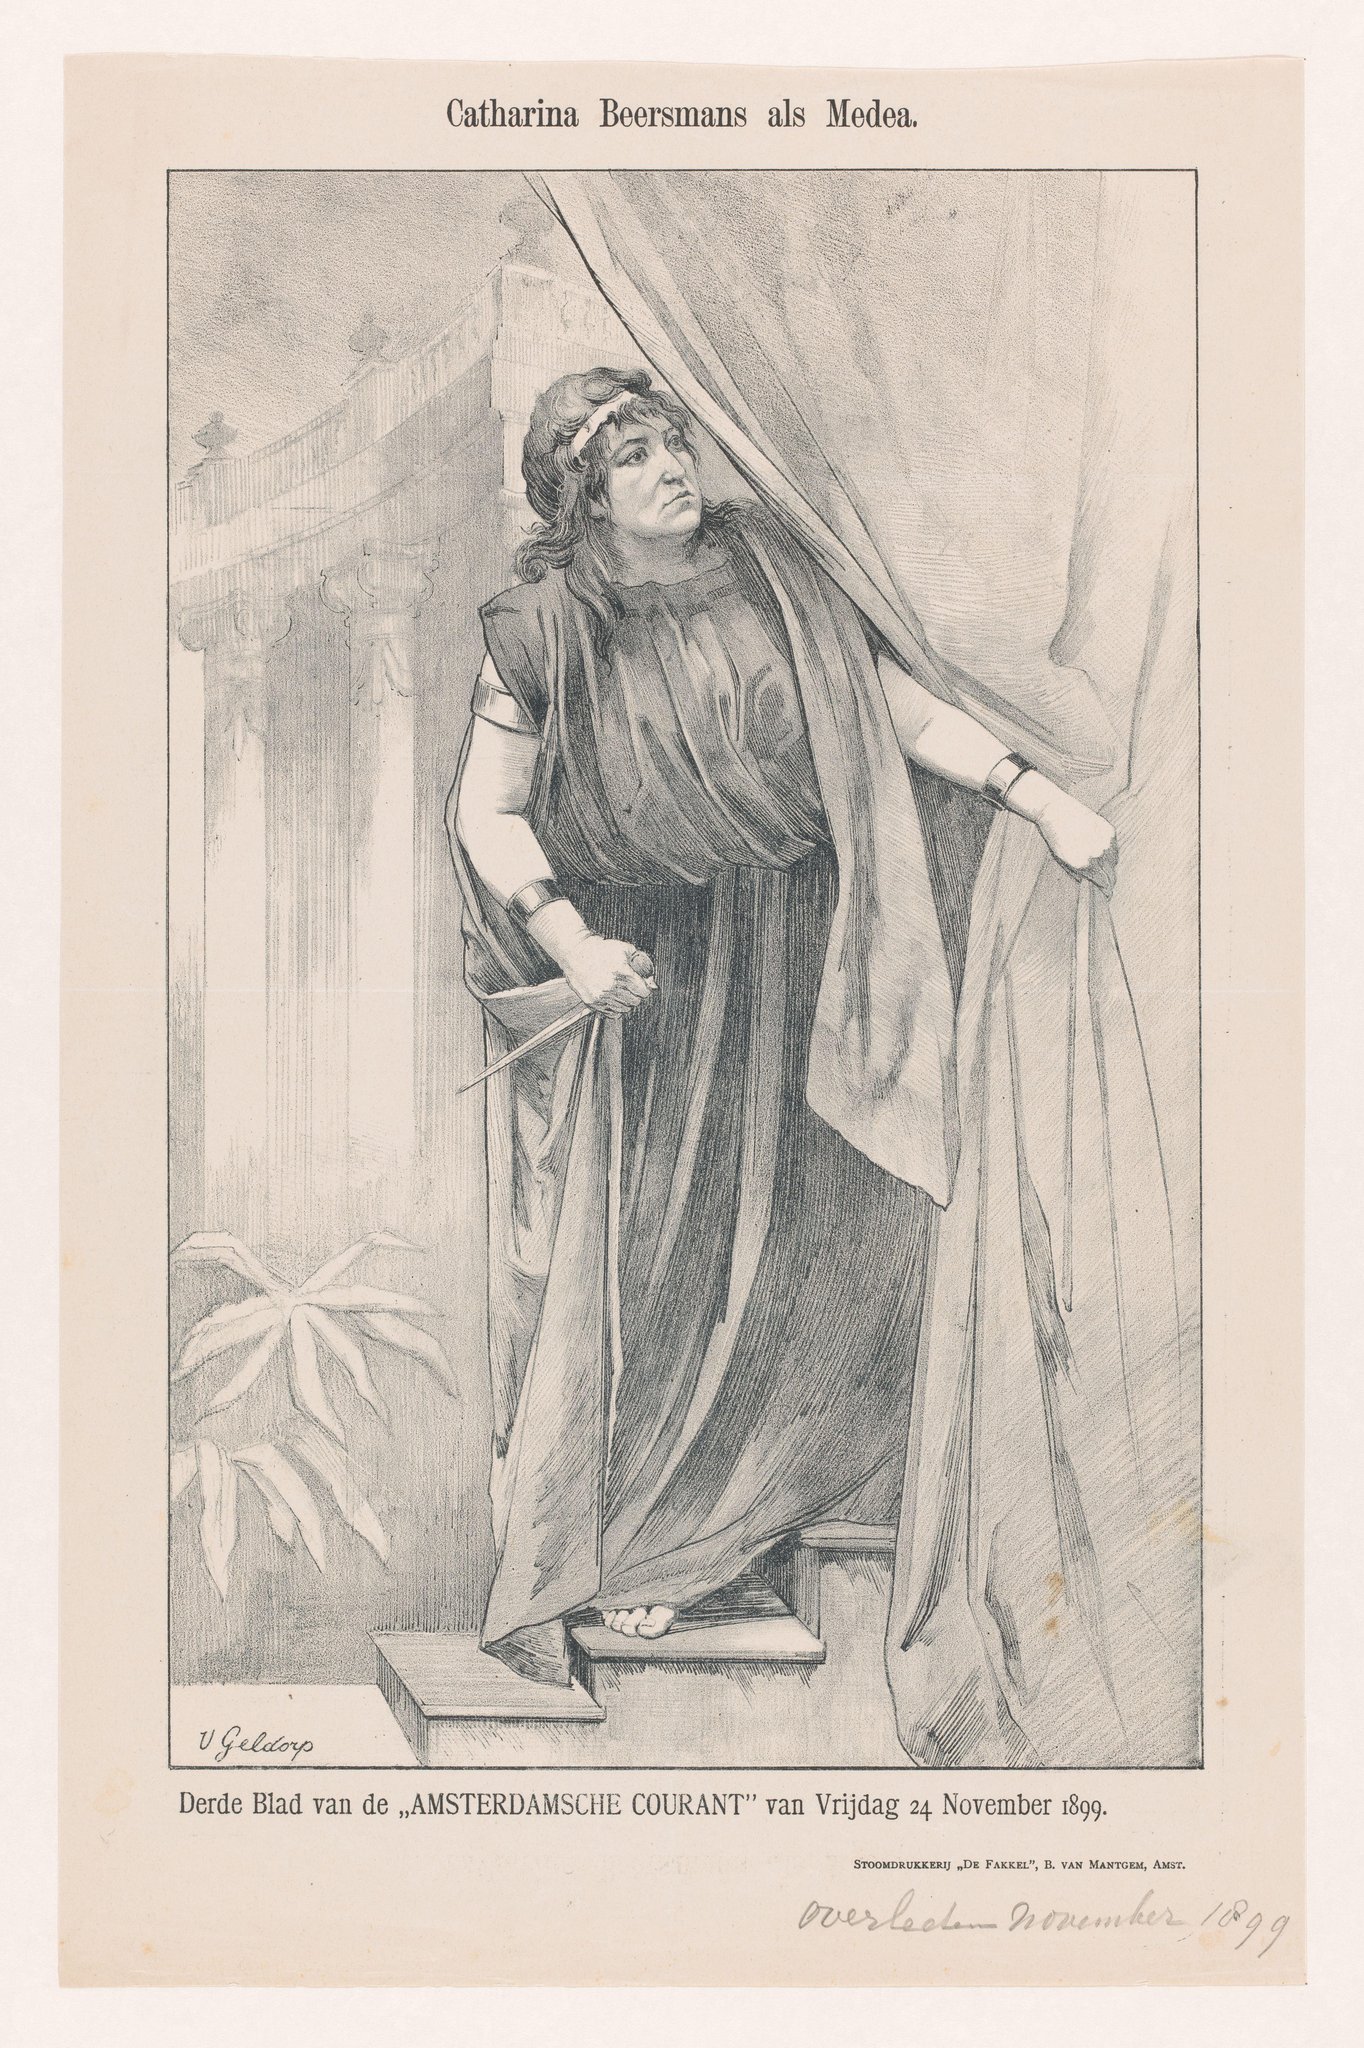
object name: print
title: Catharina Beersmans als Medea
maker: petrus van geldorp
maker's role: draughtsman, print maker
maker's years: 1872-1939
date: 1899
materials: paper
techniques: lithograph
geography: amsterdam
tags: female impersonation by actor, medea, actor (on the stage)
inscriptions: inscription: ‘overleden november, 1899’, collector's mark: Lugt 2228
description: De actrice staat op een trap en houdt een gordijn opzij. In haar rechterhand heeft zij een dolk.